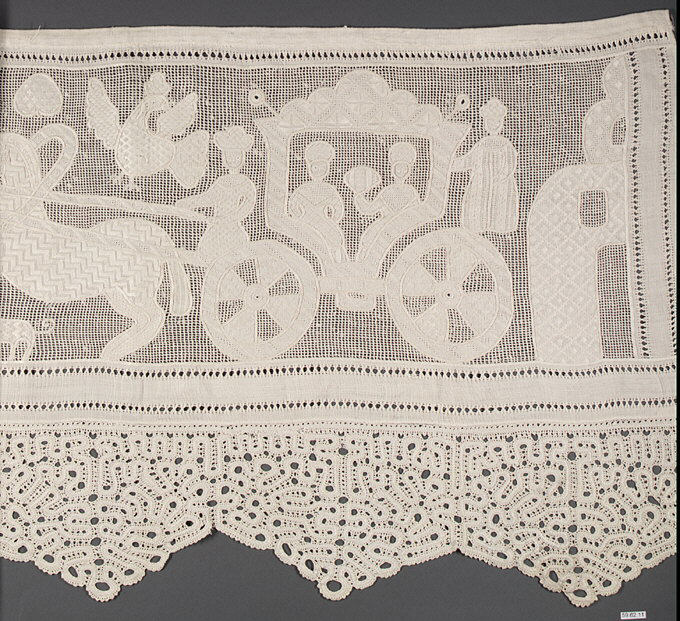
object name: flounce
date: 1801-1900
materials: linen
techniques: lace, embroidery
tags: carriages